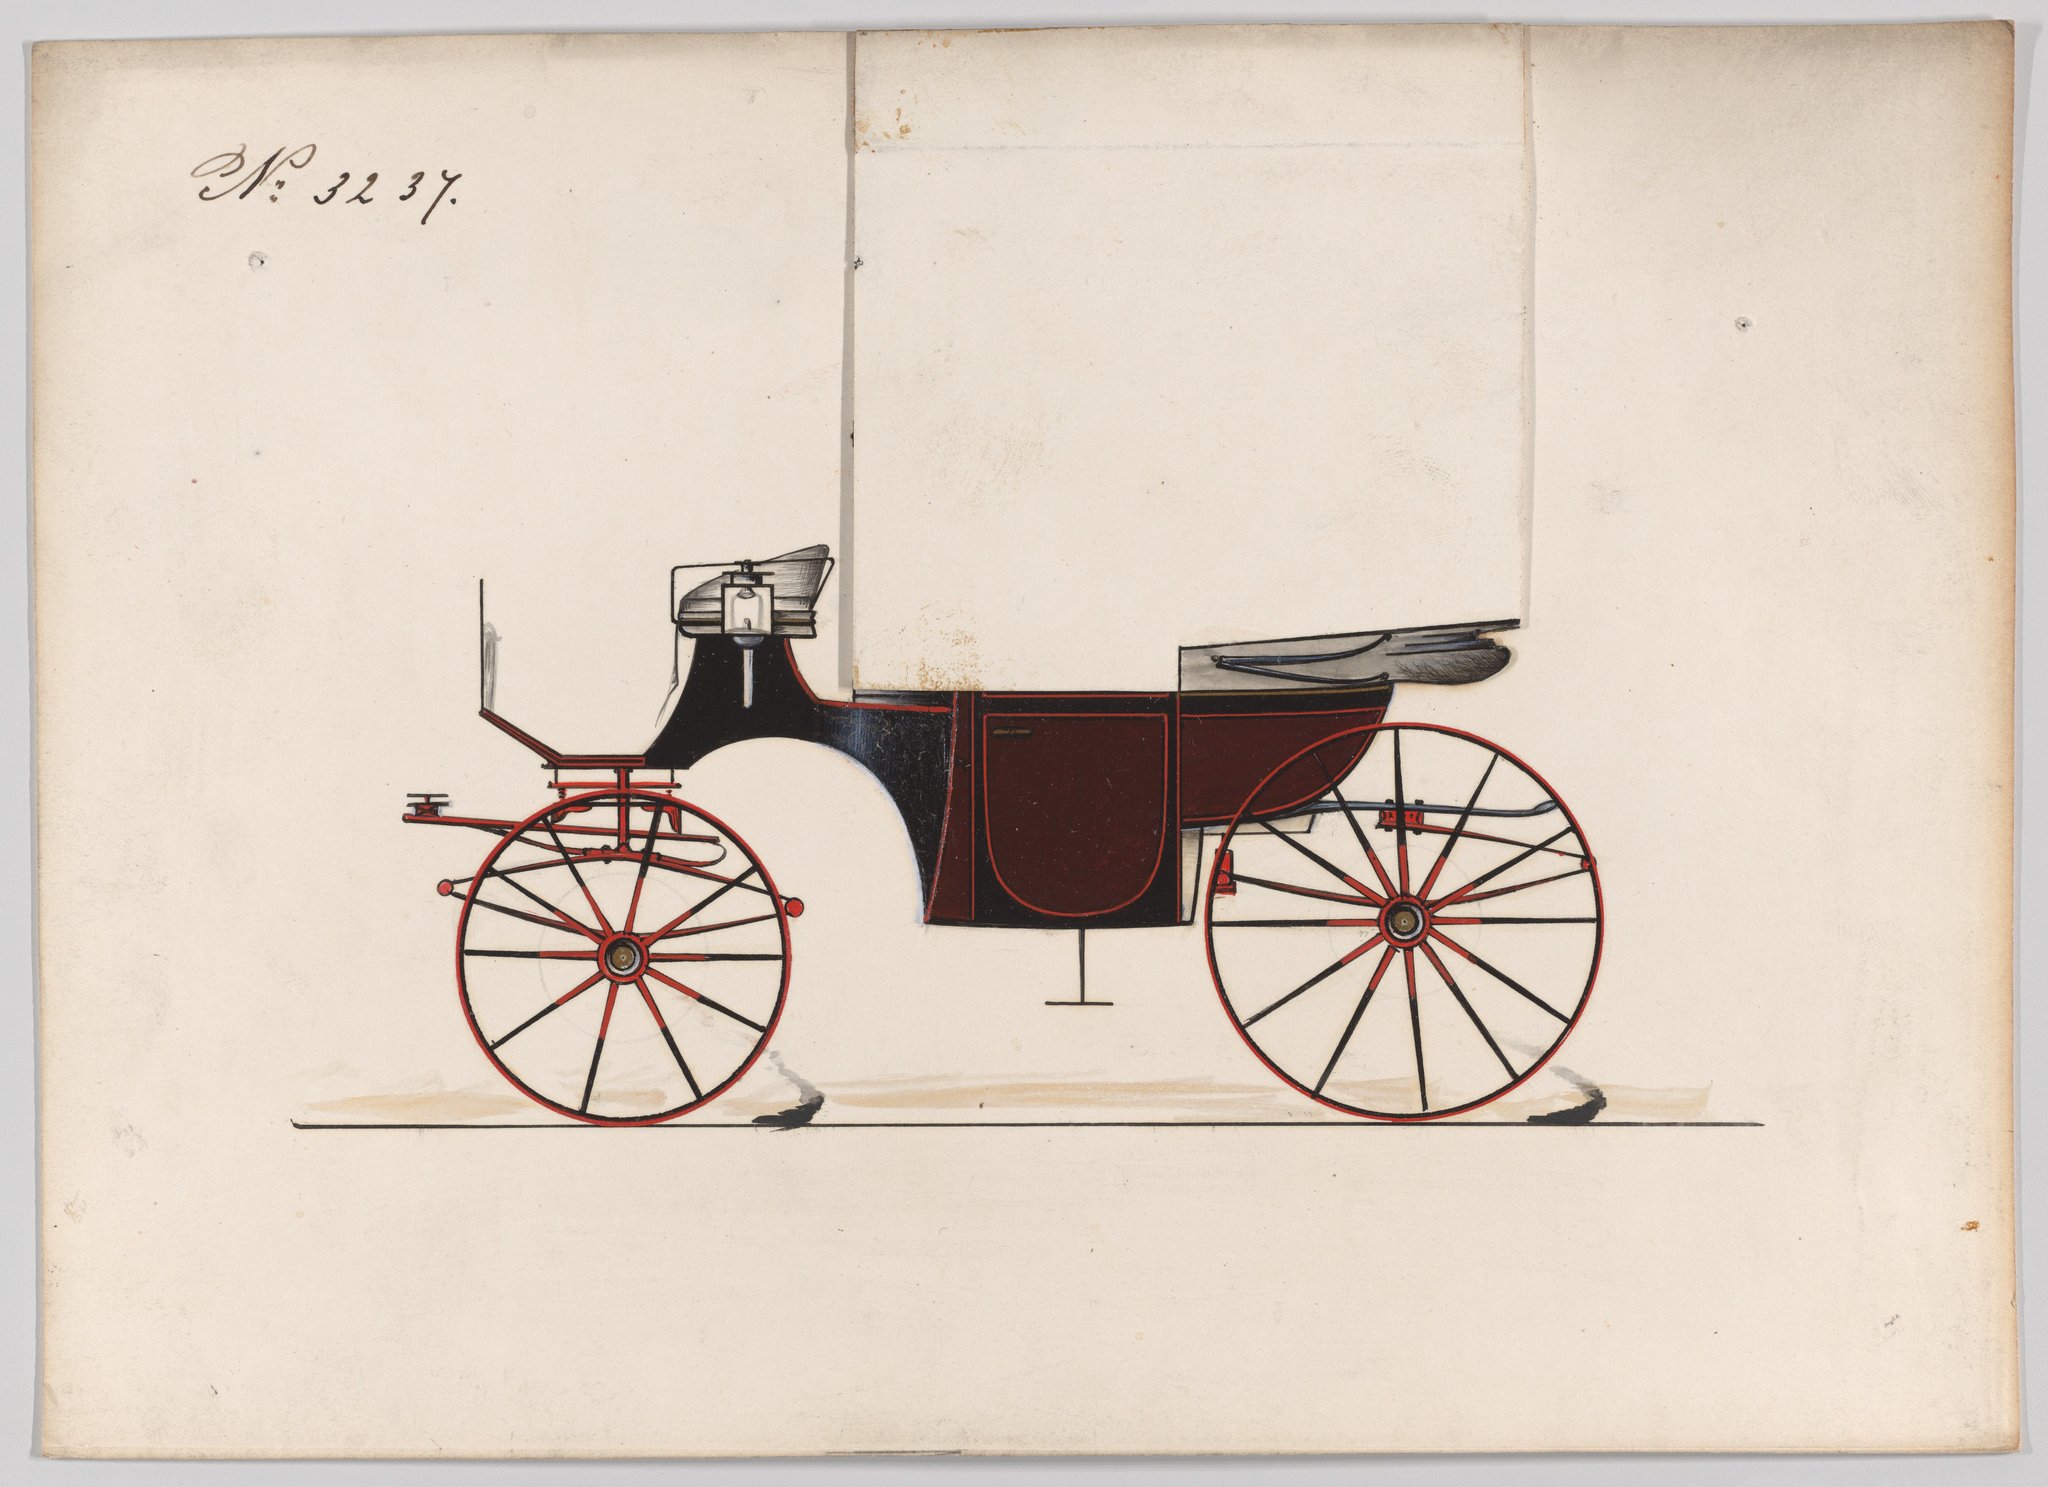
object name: drawing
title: Design for Landaulet, no. 3237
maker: brewster & co.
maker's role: manufacturer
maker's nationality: american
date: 1876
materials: gouache, gum arabic, ink, watercolor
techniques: pen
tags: carriages